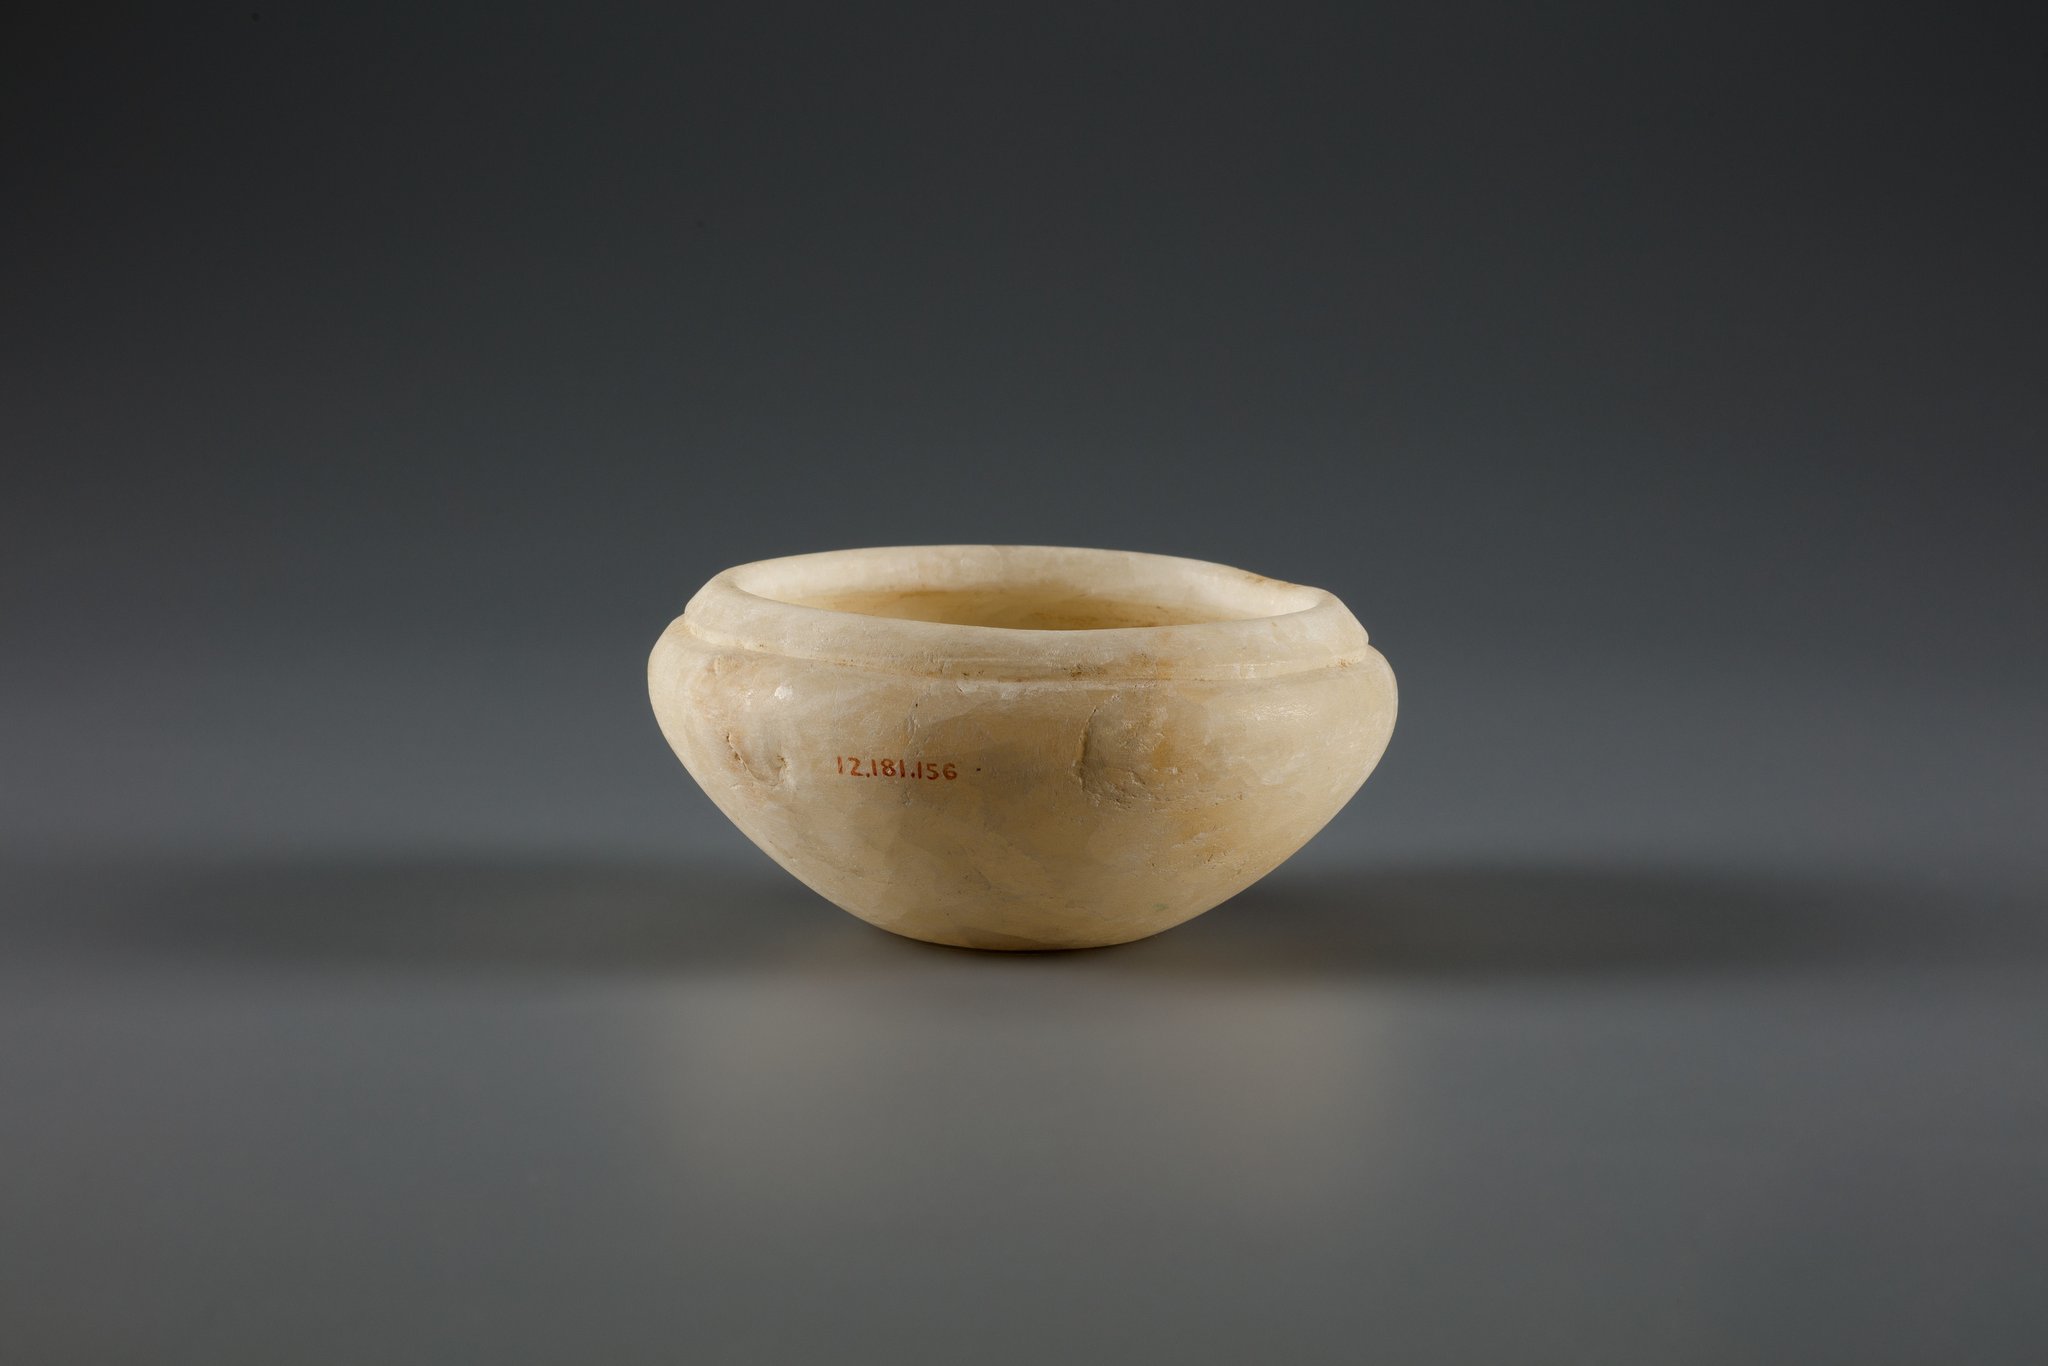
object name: bowl, rimmed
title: Small Rimmed Bowl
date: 2750-2649 BCE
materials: stone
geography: egypt